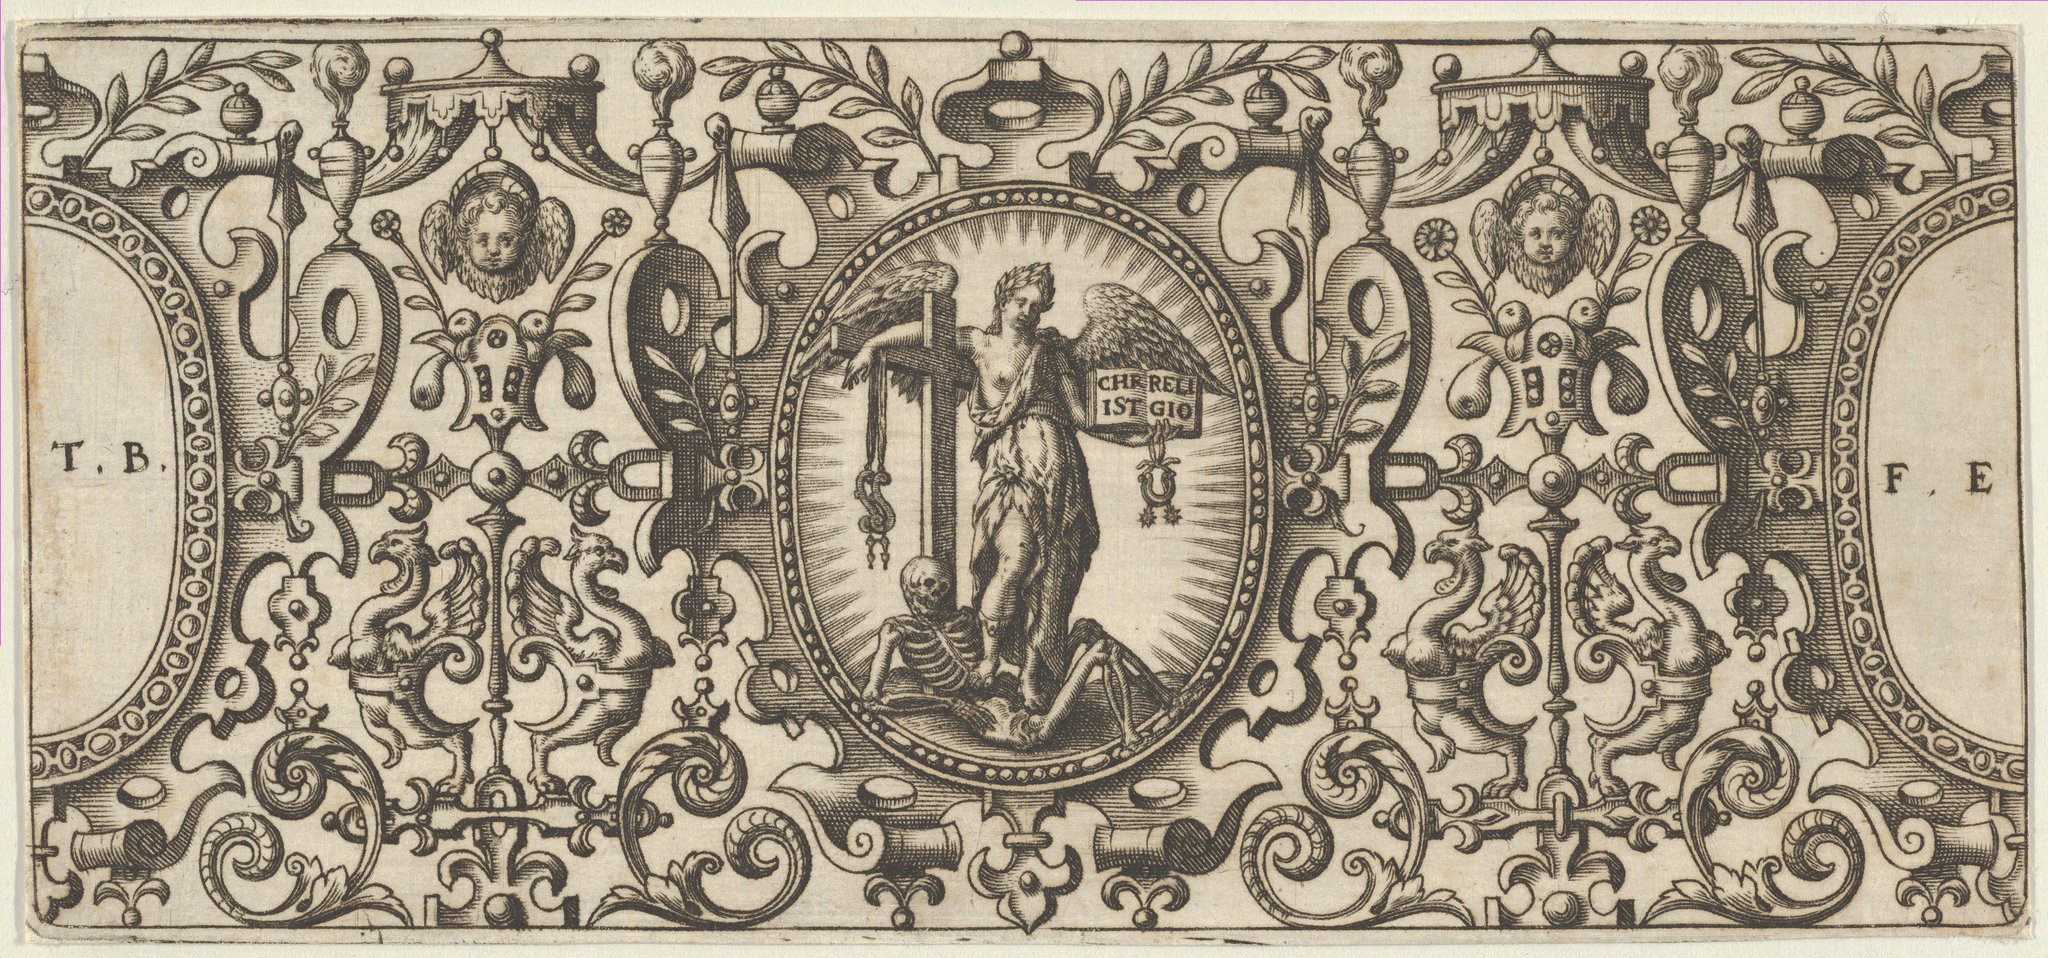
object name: print ornament architecture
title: An Angel Trampling a Skeleton, from Grotisch fur alle Kunstler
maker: theodor de bry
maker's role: artist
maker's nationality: netherlandish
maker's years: 1528-1598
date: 1580-1600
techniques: engraving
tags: skeletons,angels